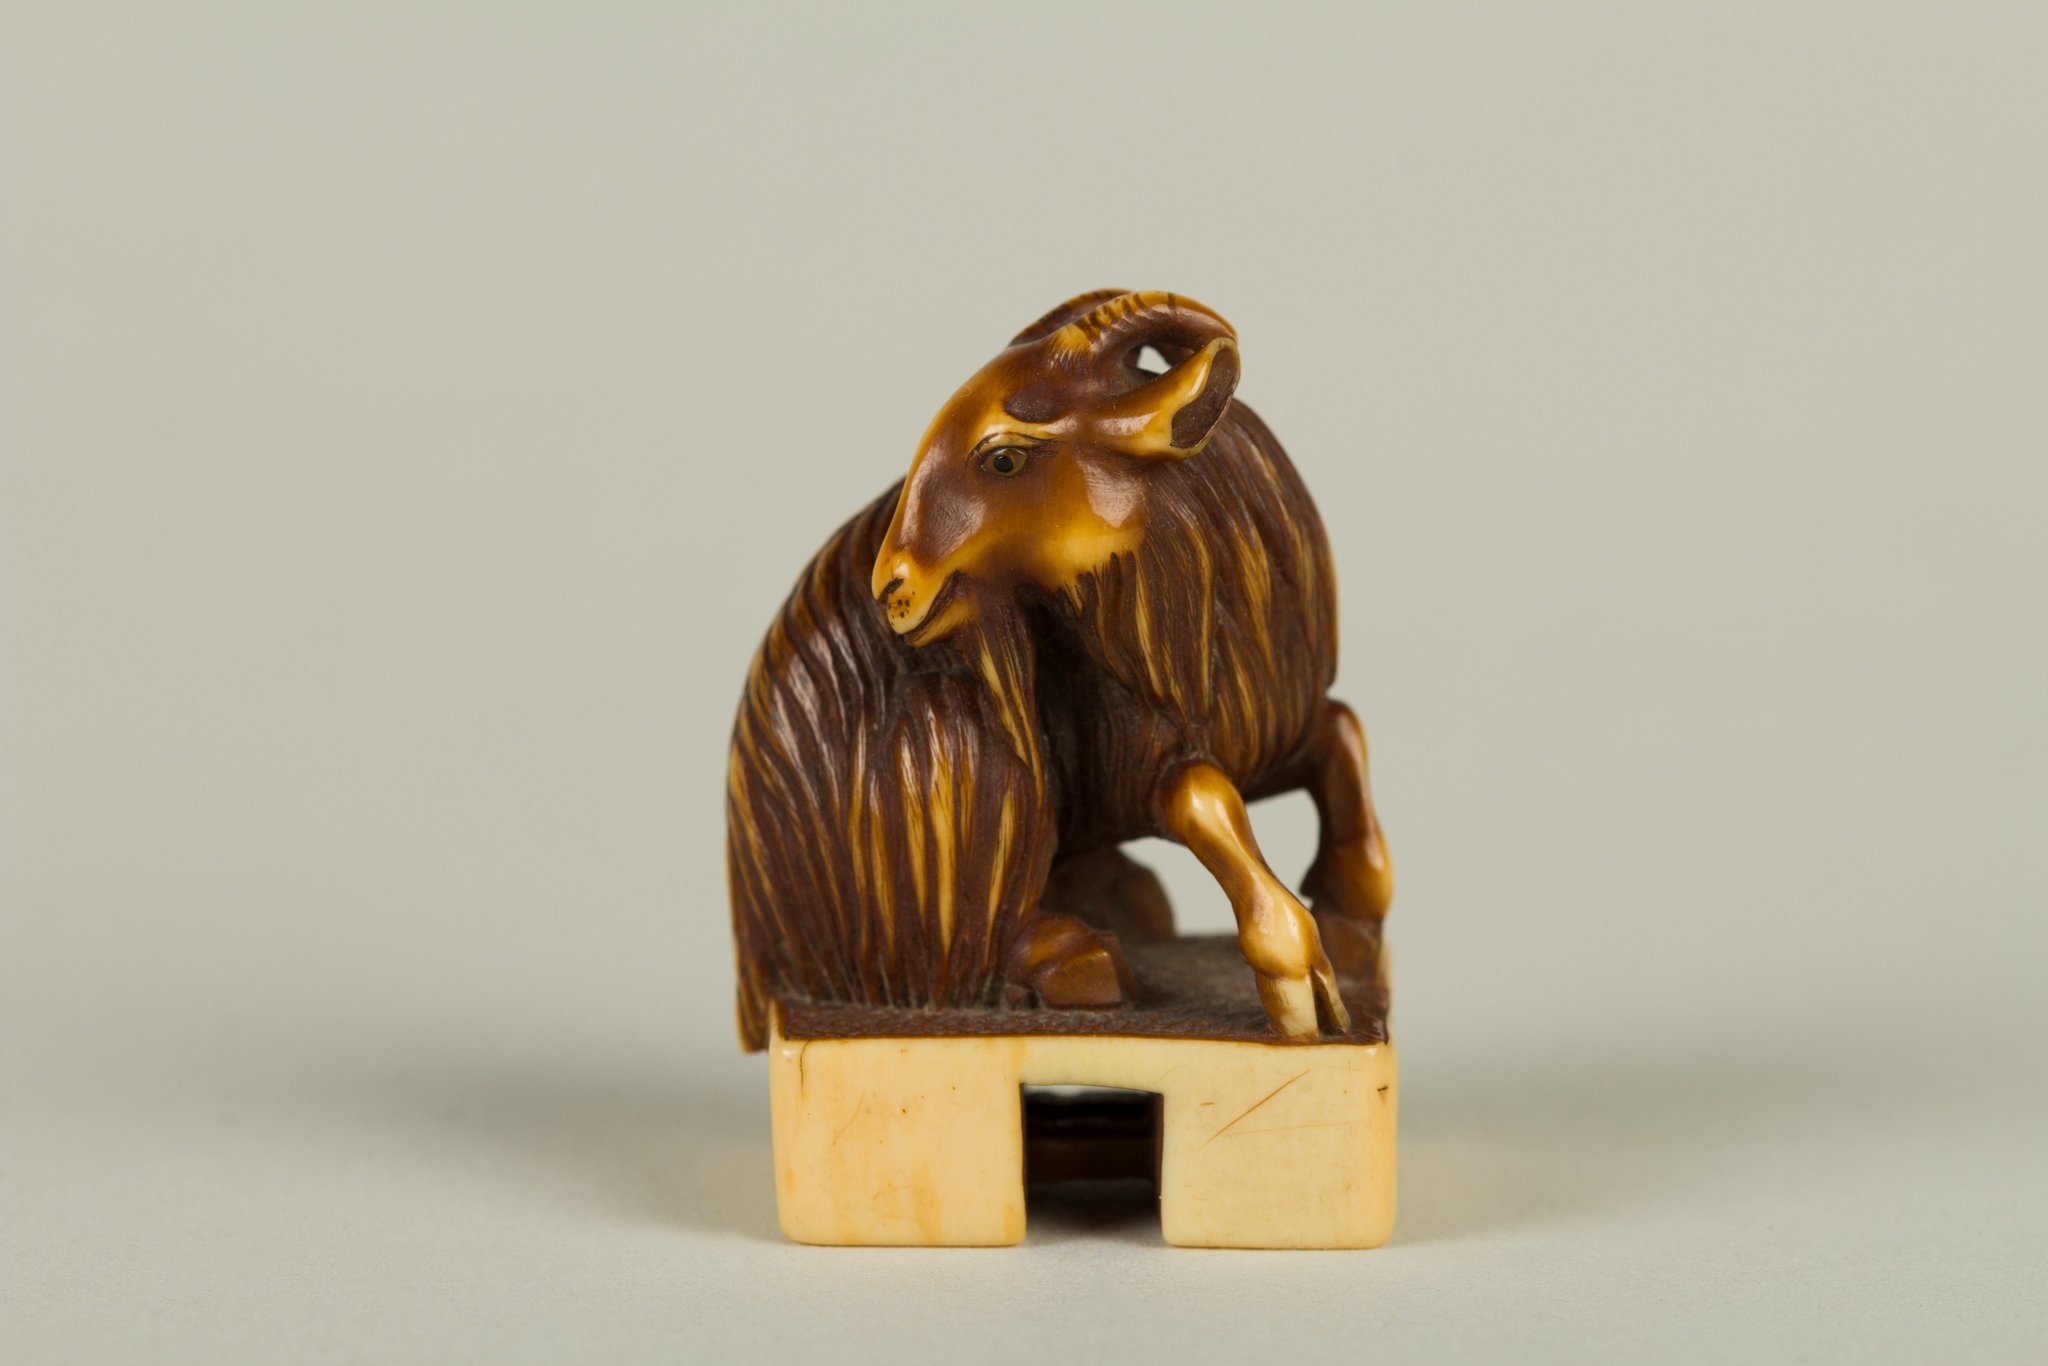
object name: netsuke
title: Netsuke of Goat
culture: japanese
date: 1701-1800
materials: ivory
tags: goats